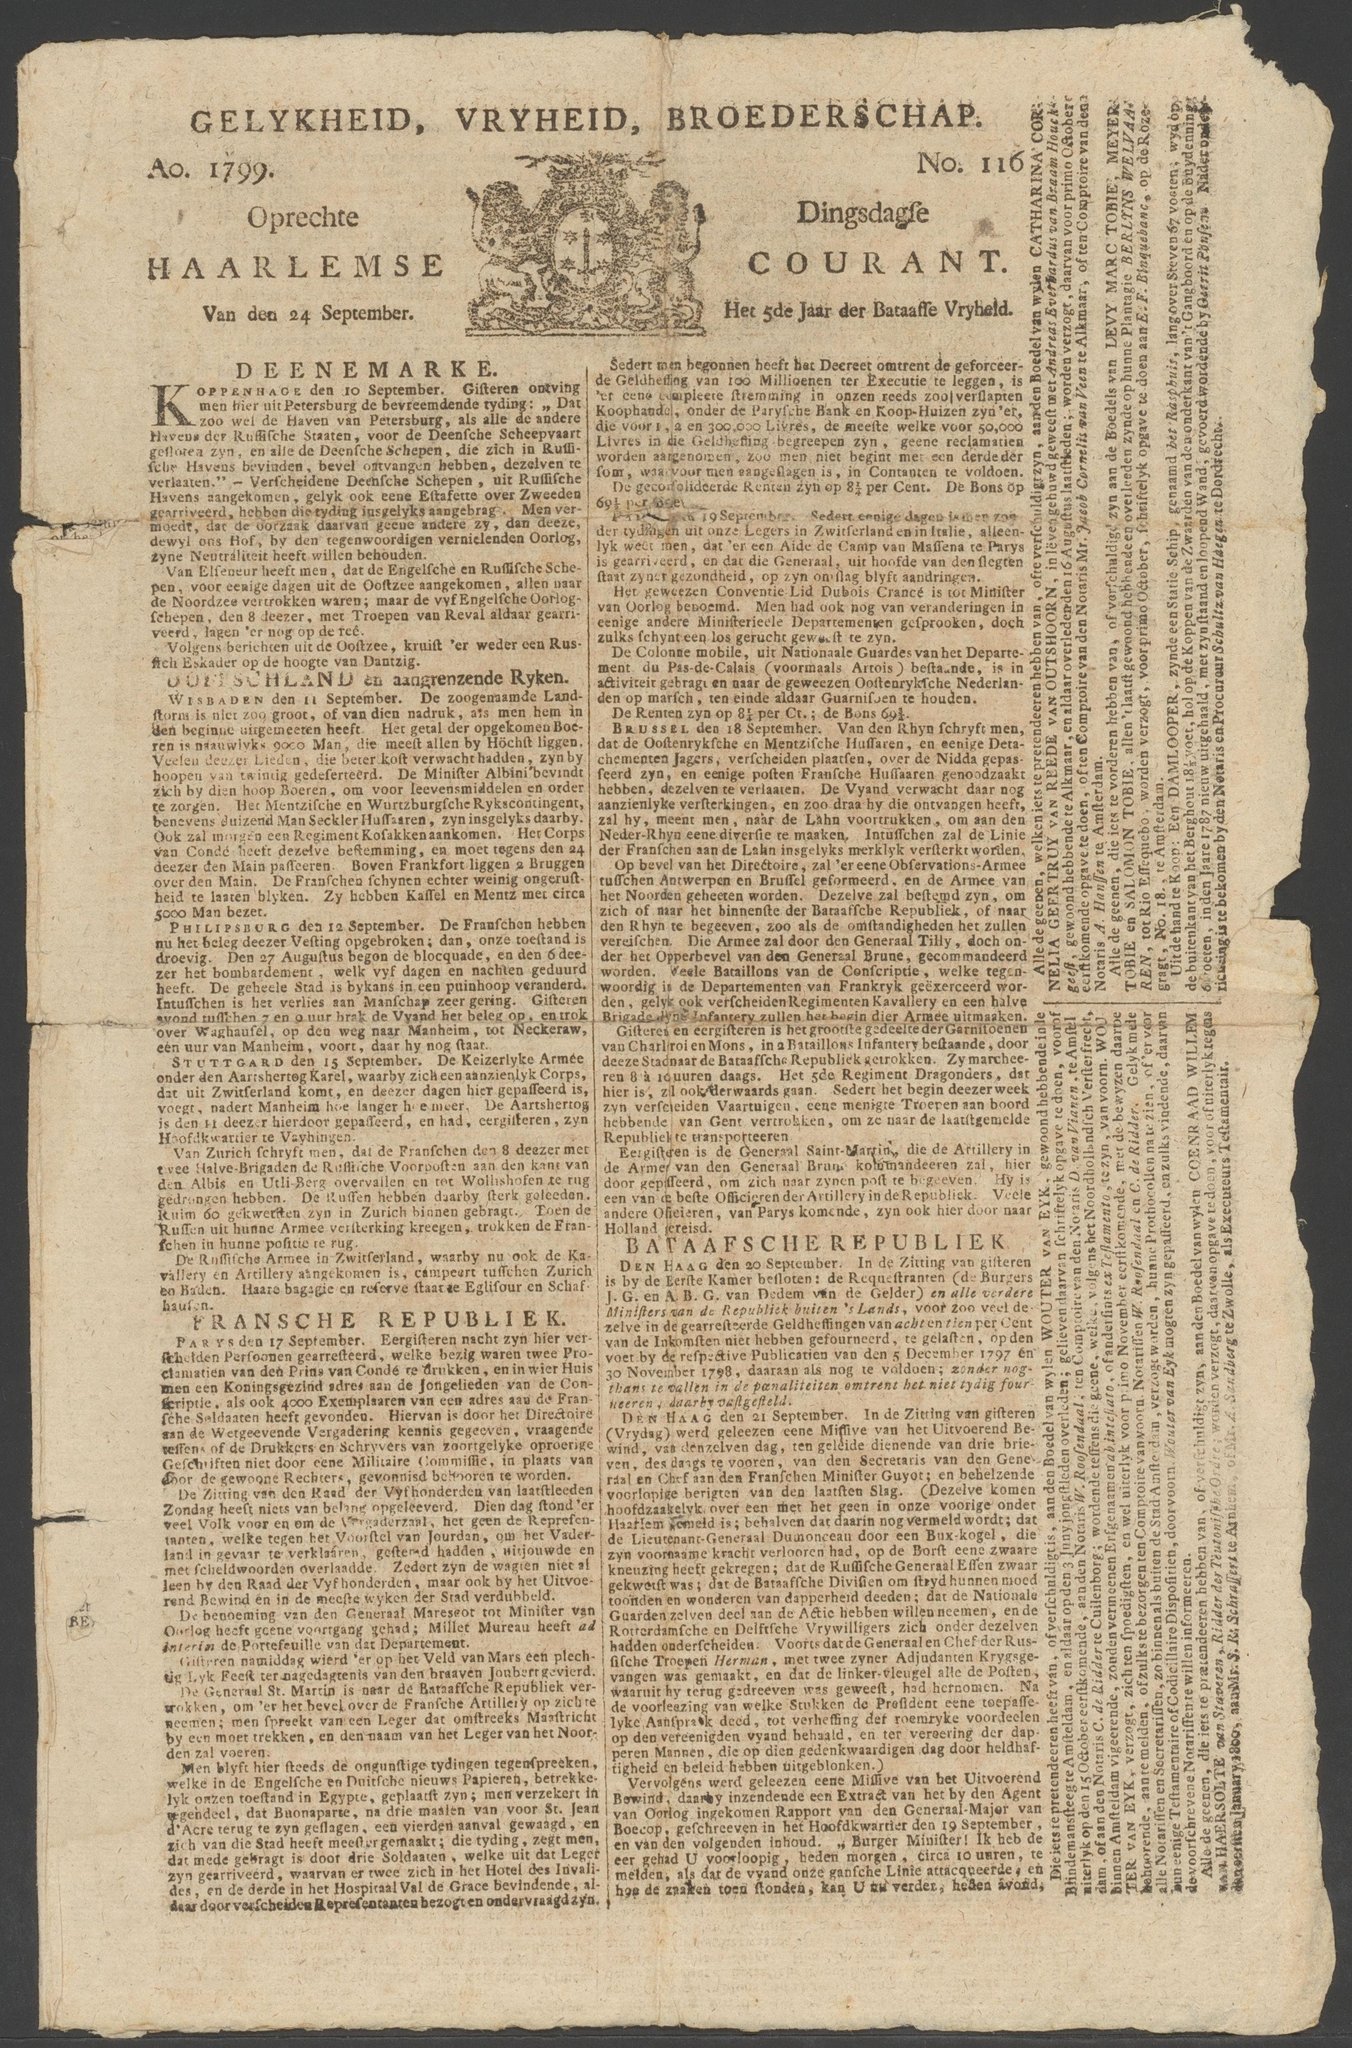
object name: newspaper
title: Oprechte Haarlemse Courant, 24 september 1799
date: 1799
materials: paper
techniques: letterpress printing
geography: haarlem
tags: newspaper, news-sheet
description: Exemplaar van de krant 'Oprechte Dinsdagse Haarlemse Courant', 24 september 1799. Dubbelbladig, alle zijden bedrukt. Bovenaan een vignet met het stadswapen. Onderwerpsrubrieken binnen de Atlas Zeden en Gewoonten: Regeering, Officieele Nieuwsbladen.